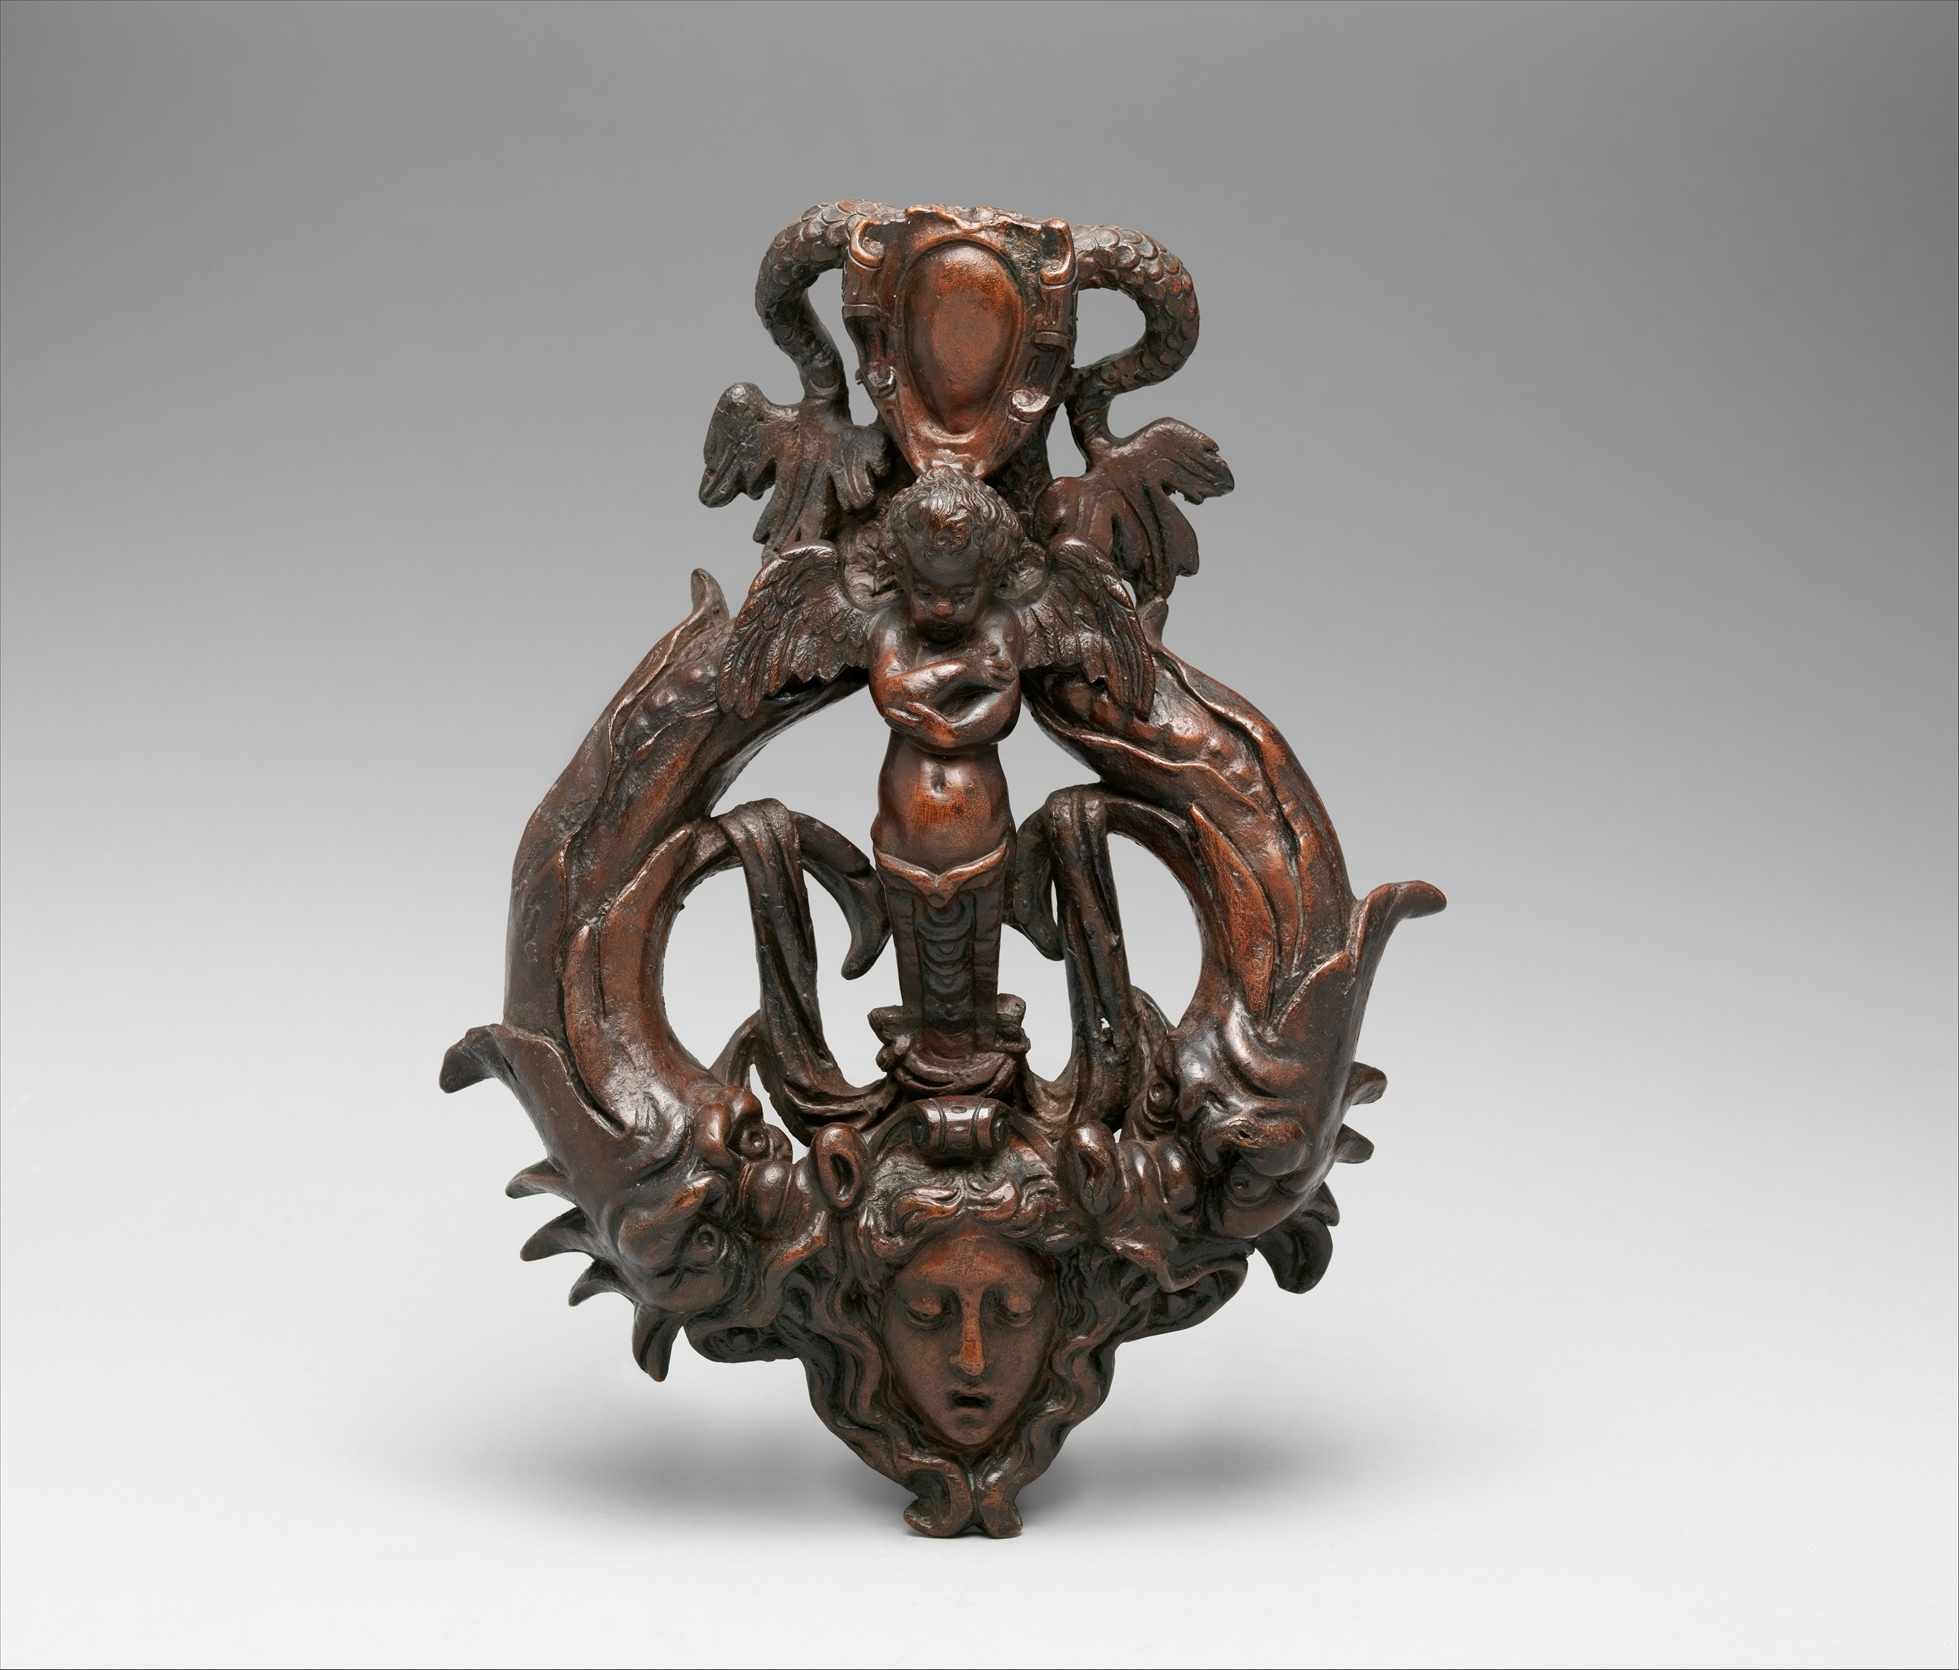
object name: door knocker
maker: elkington & co.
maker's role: manufacturer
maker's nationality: british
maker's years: 1829-1963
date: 1801-1900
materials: bronze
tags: putti